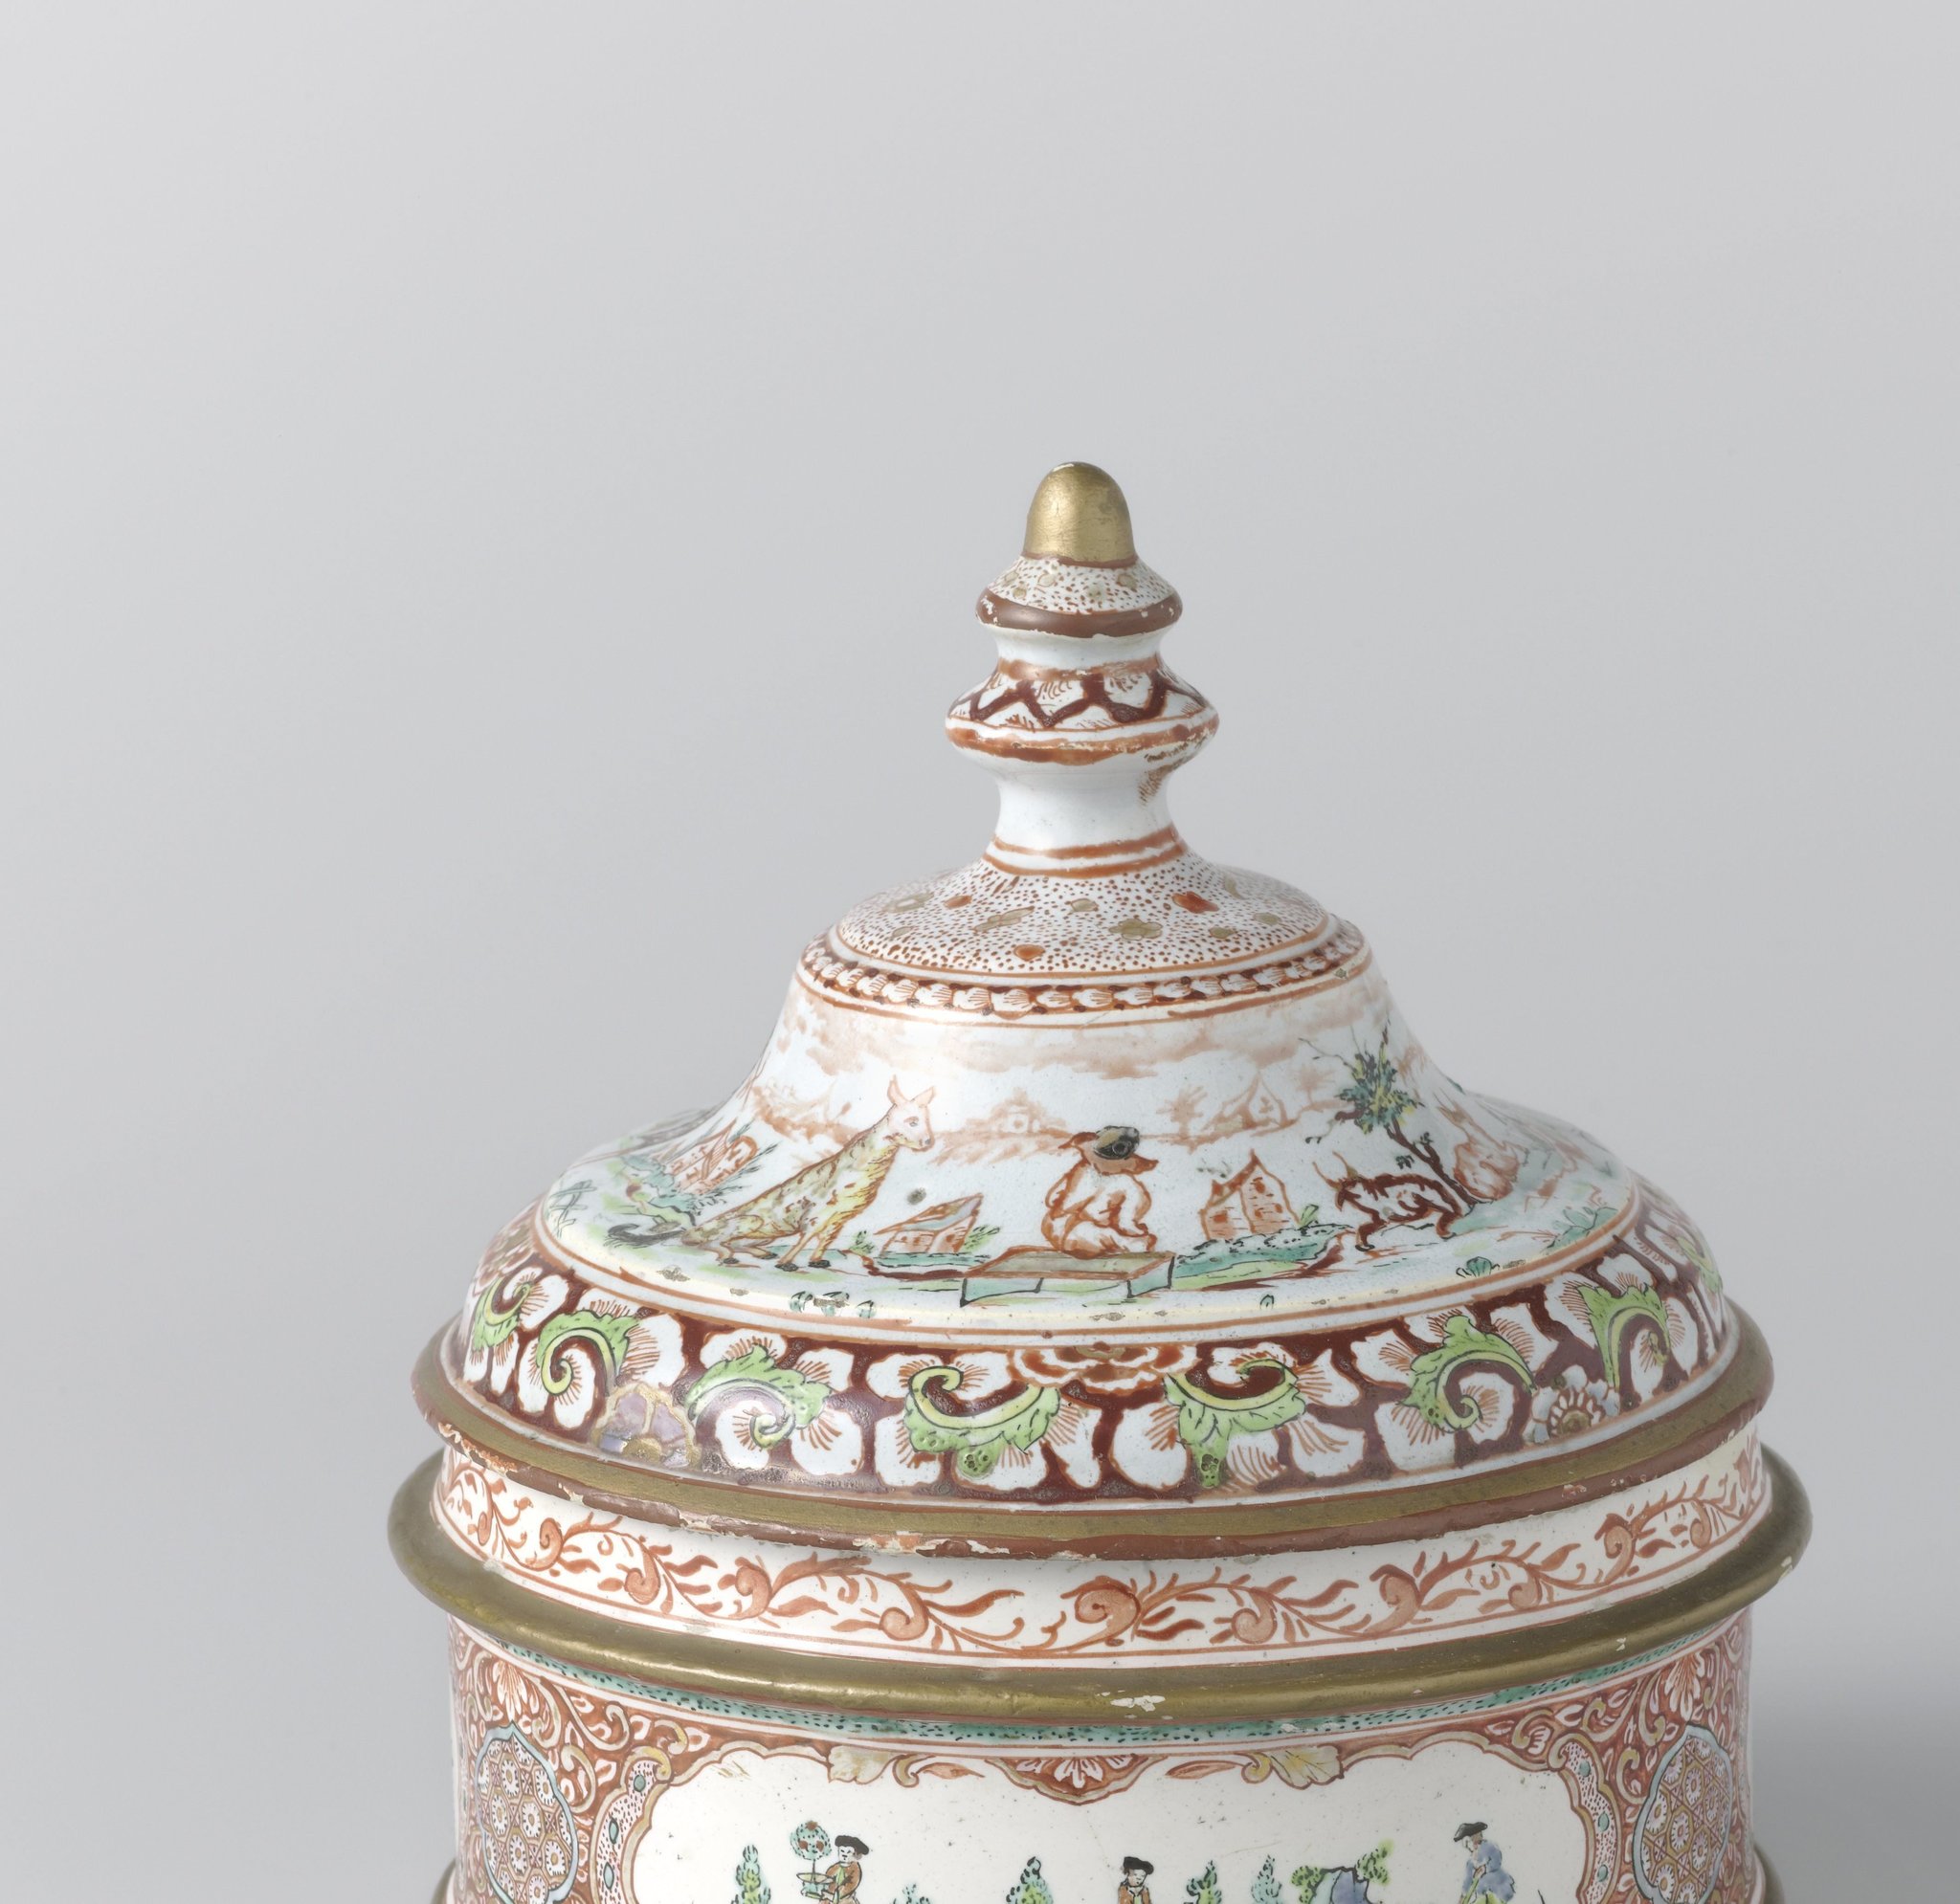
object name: tobacco jar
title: Tabakspot, veelkleurig beschilderd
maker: Anonymous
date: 1740-1770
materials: faience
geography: delft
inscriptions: collector's mark: ‘collection J.F. Loudon’, inscription: ‘569’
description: Tabakspot van faïence, veelkleurig beschilderd. De tabakspot werd geschonken tezamen met een deksel (A). Het deksel en de pot horen oorspronkelijk niet bij elkaar.